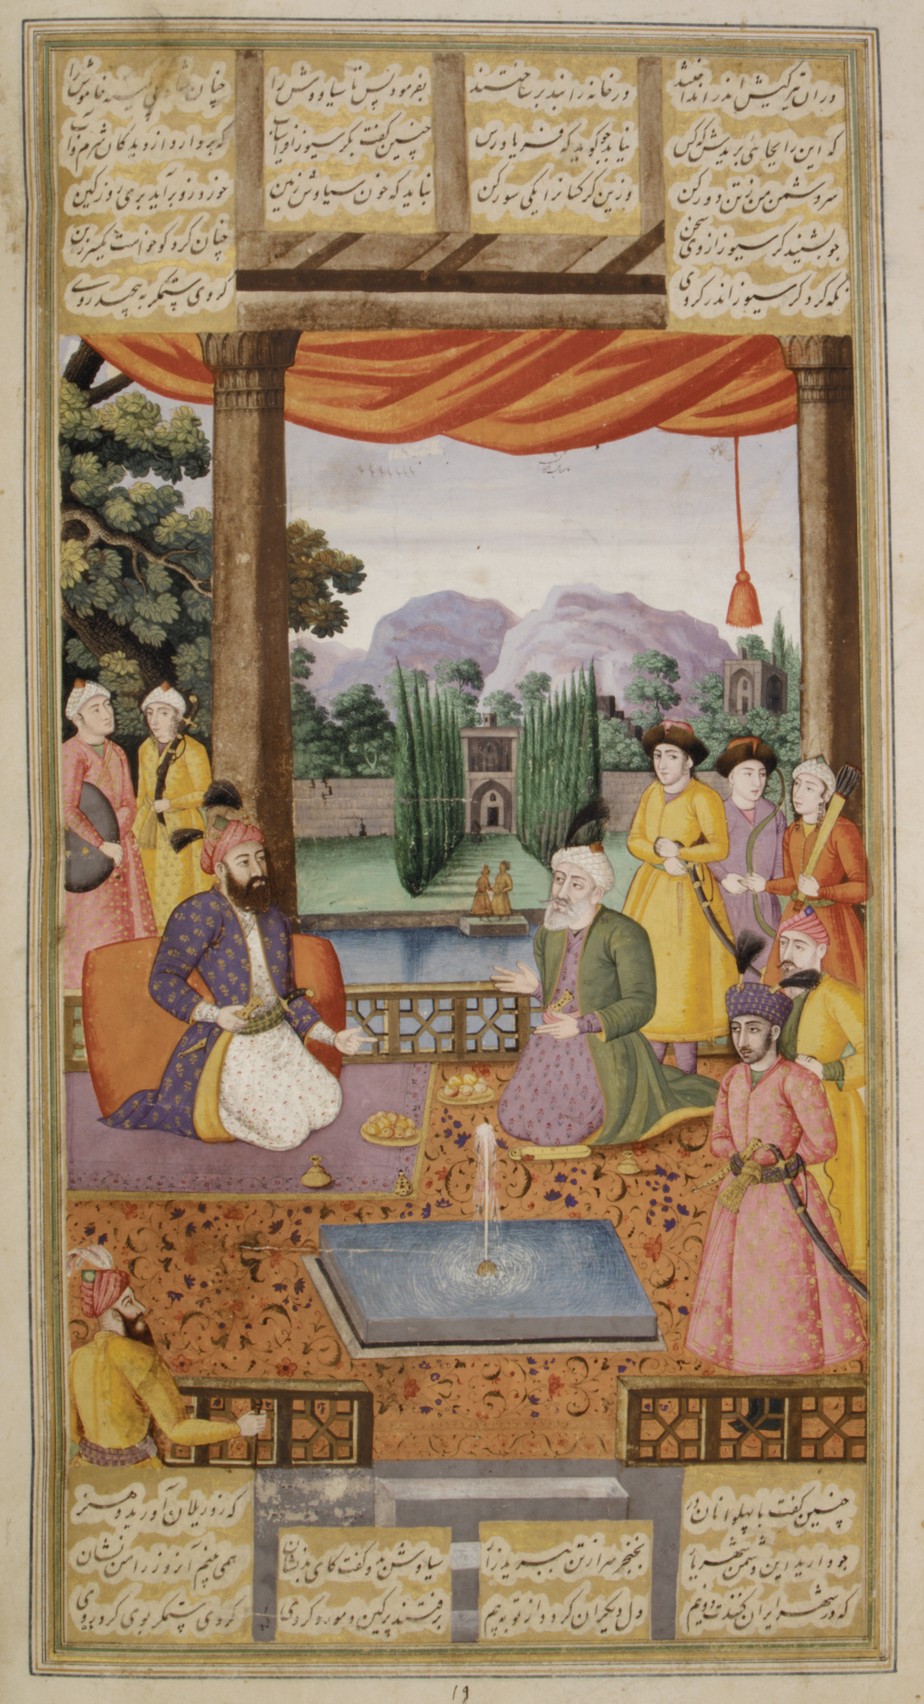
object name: illustrated manuscript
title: Shahnama (Book of Kings) of Firdausi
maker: abu'l qasim firdausi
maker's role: author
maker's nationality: iranian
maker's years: 935-1020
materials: gold, ink, paper, silver, watercolor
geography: iran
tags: fountains,men